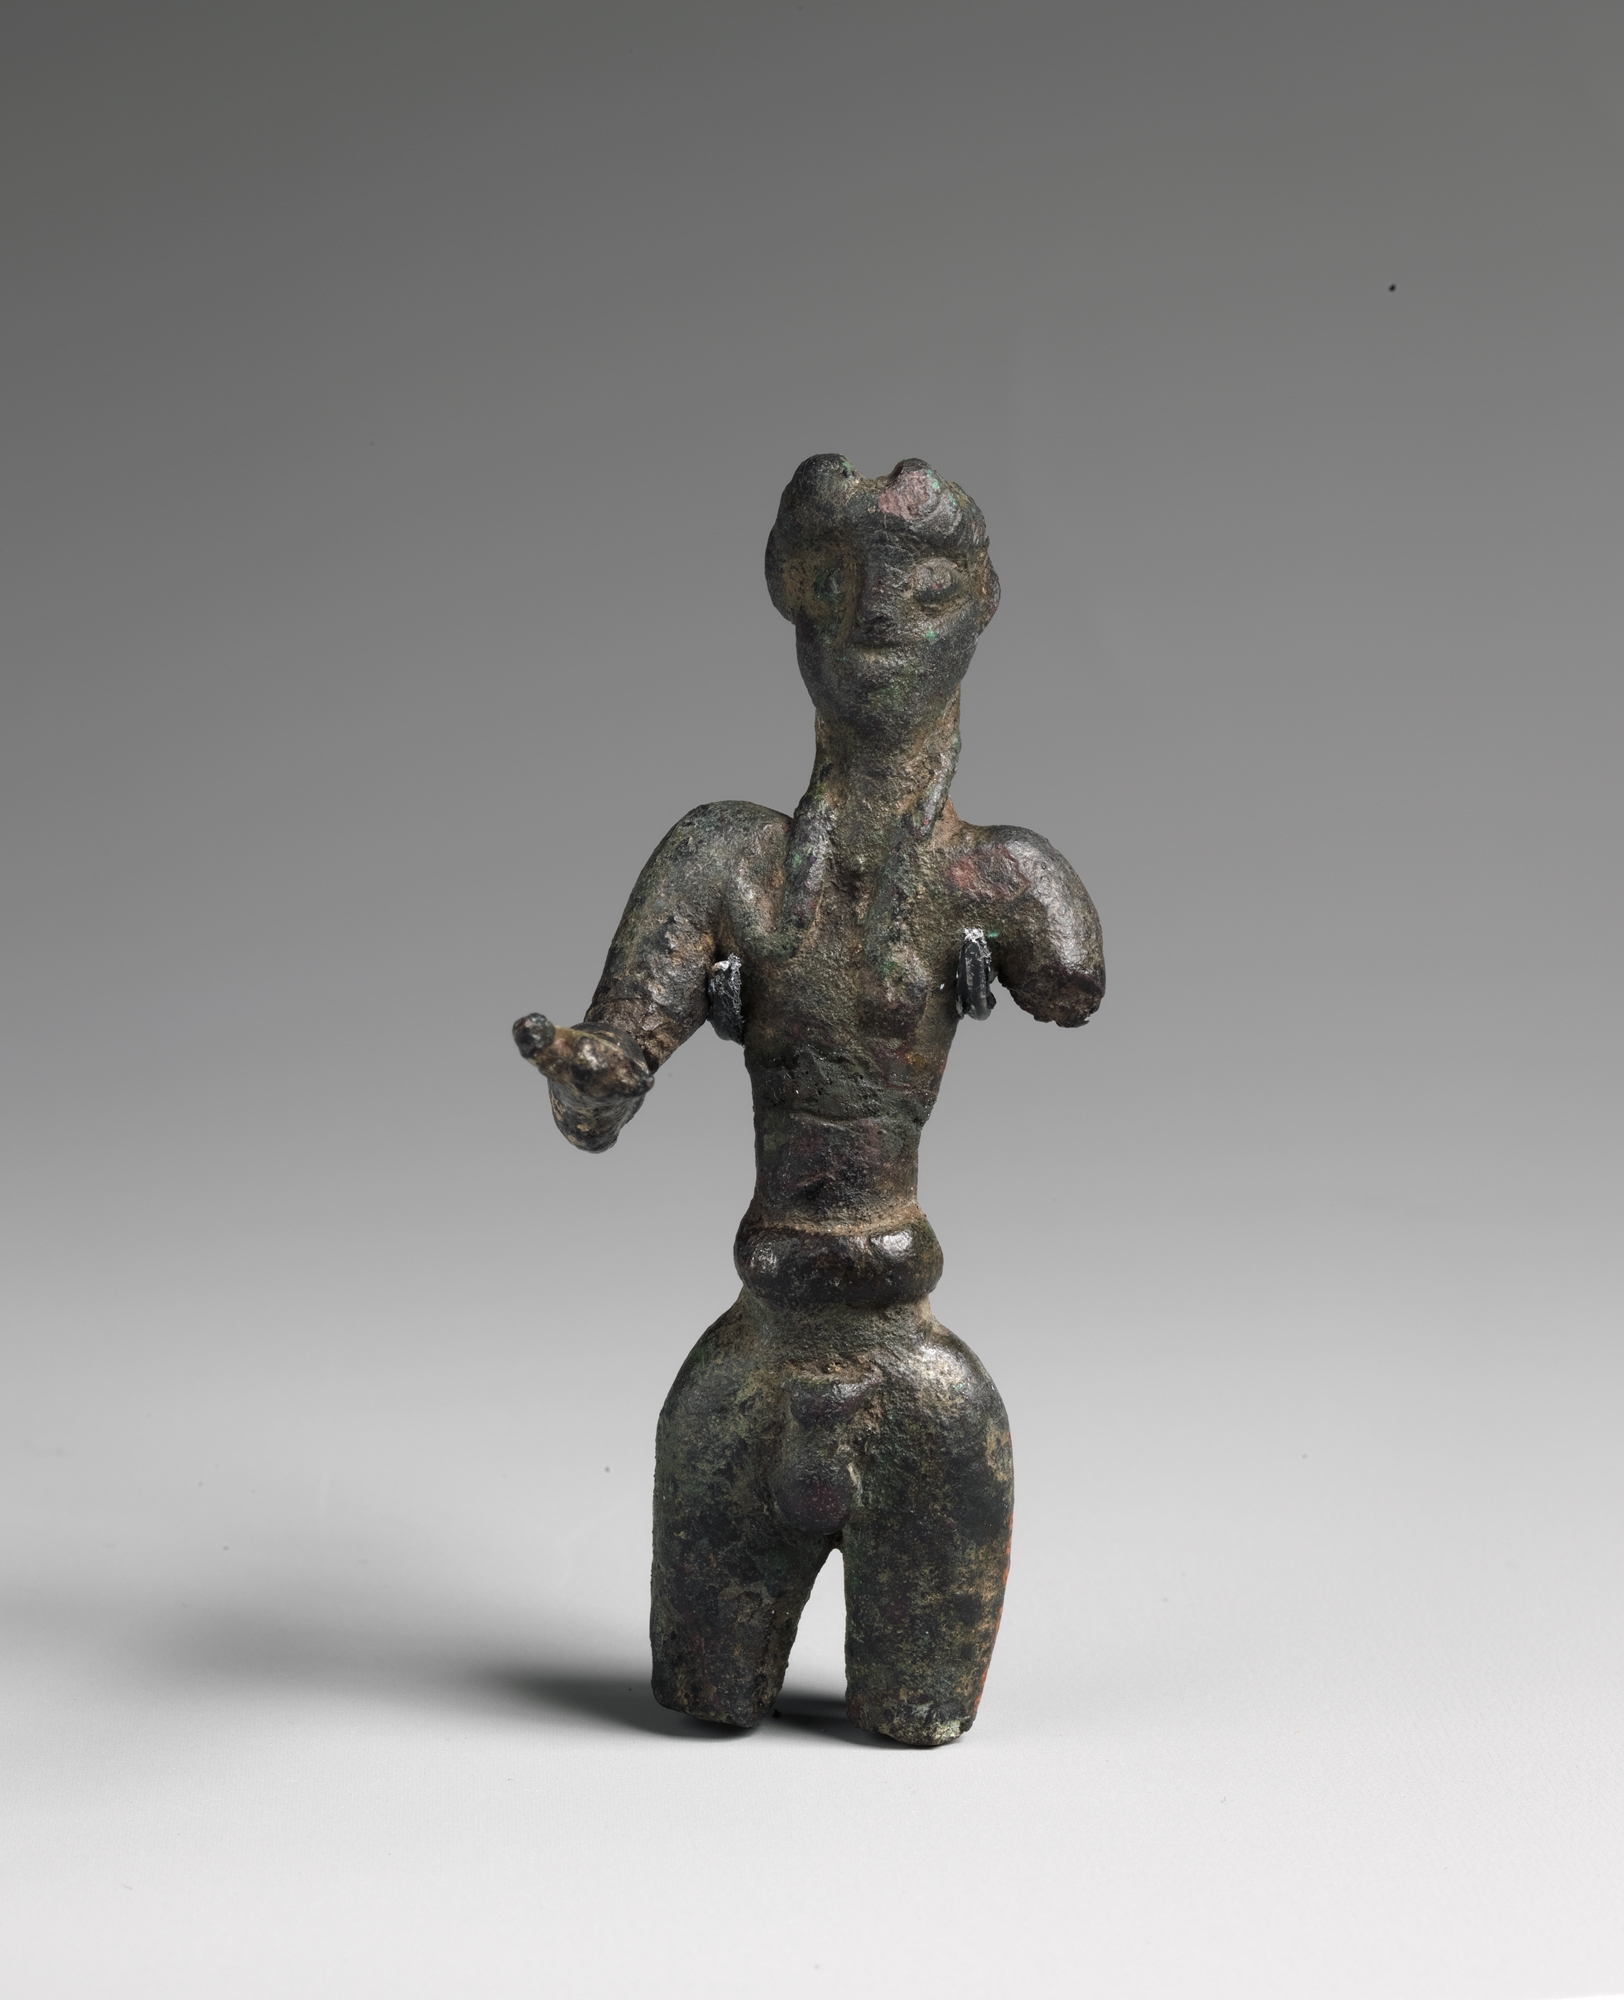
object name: statuette of a man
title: Bronze male figure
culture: minoan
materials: bronze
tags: men